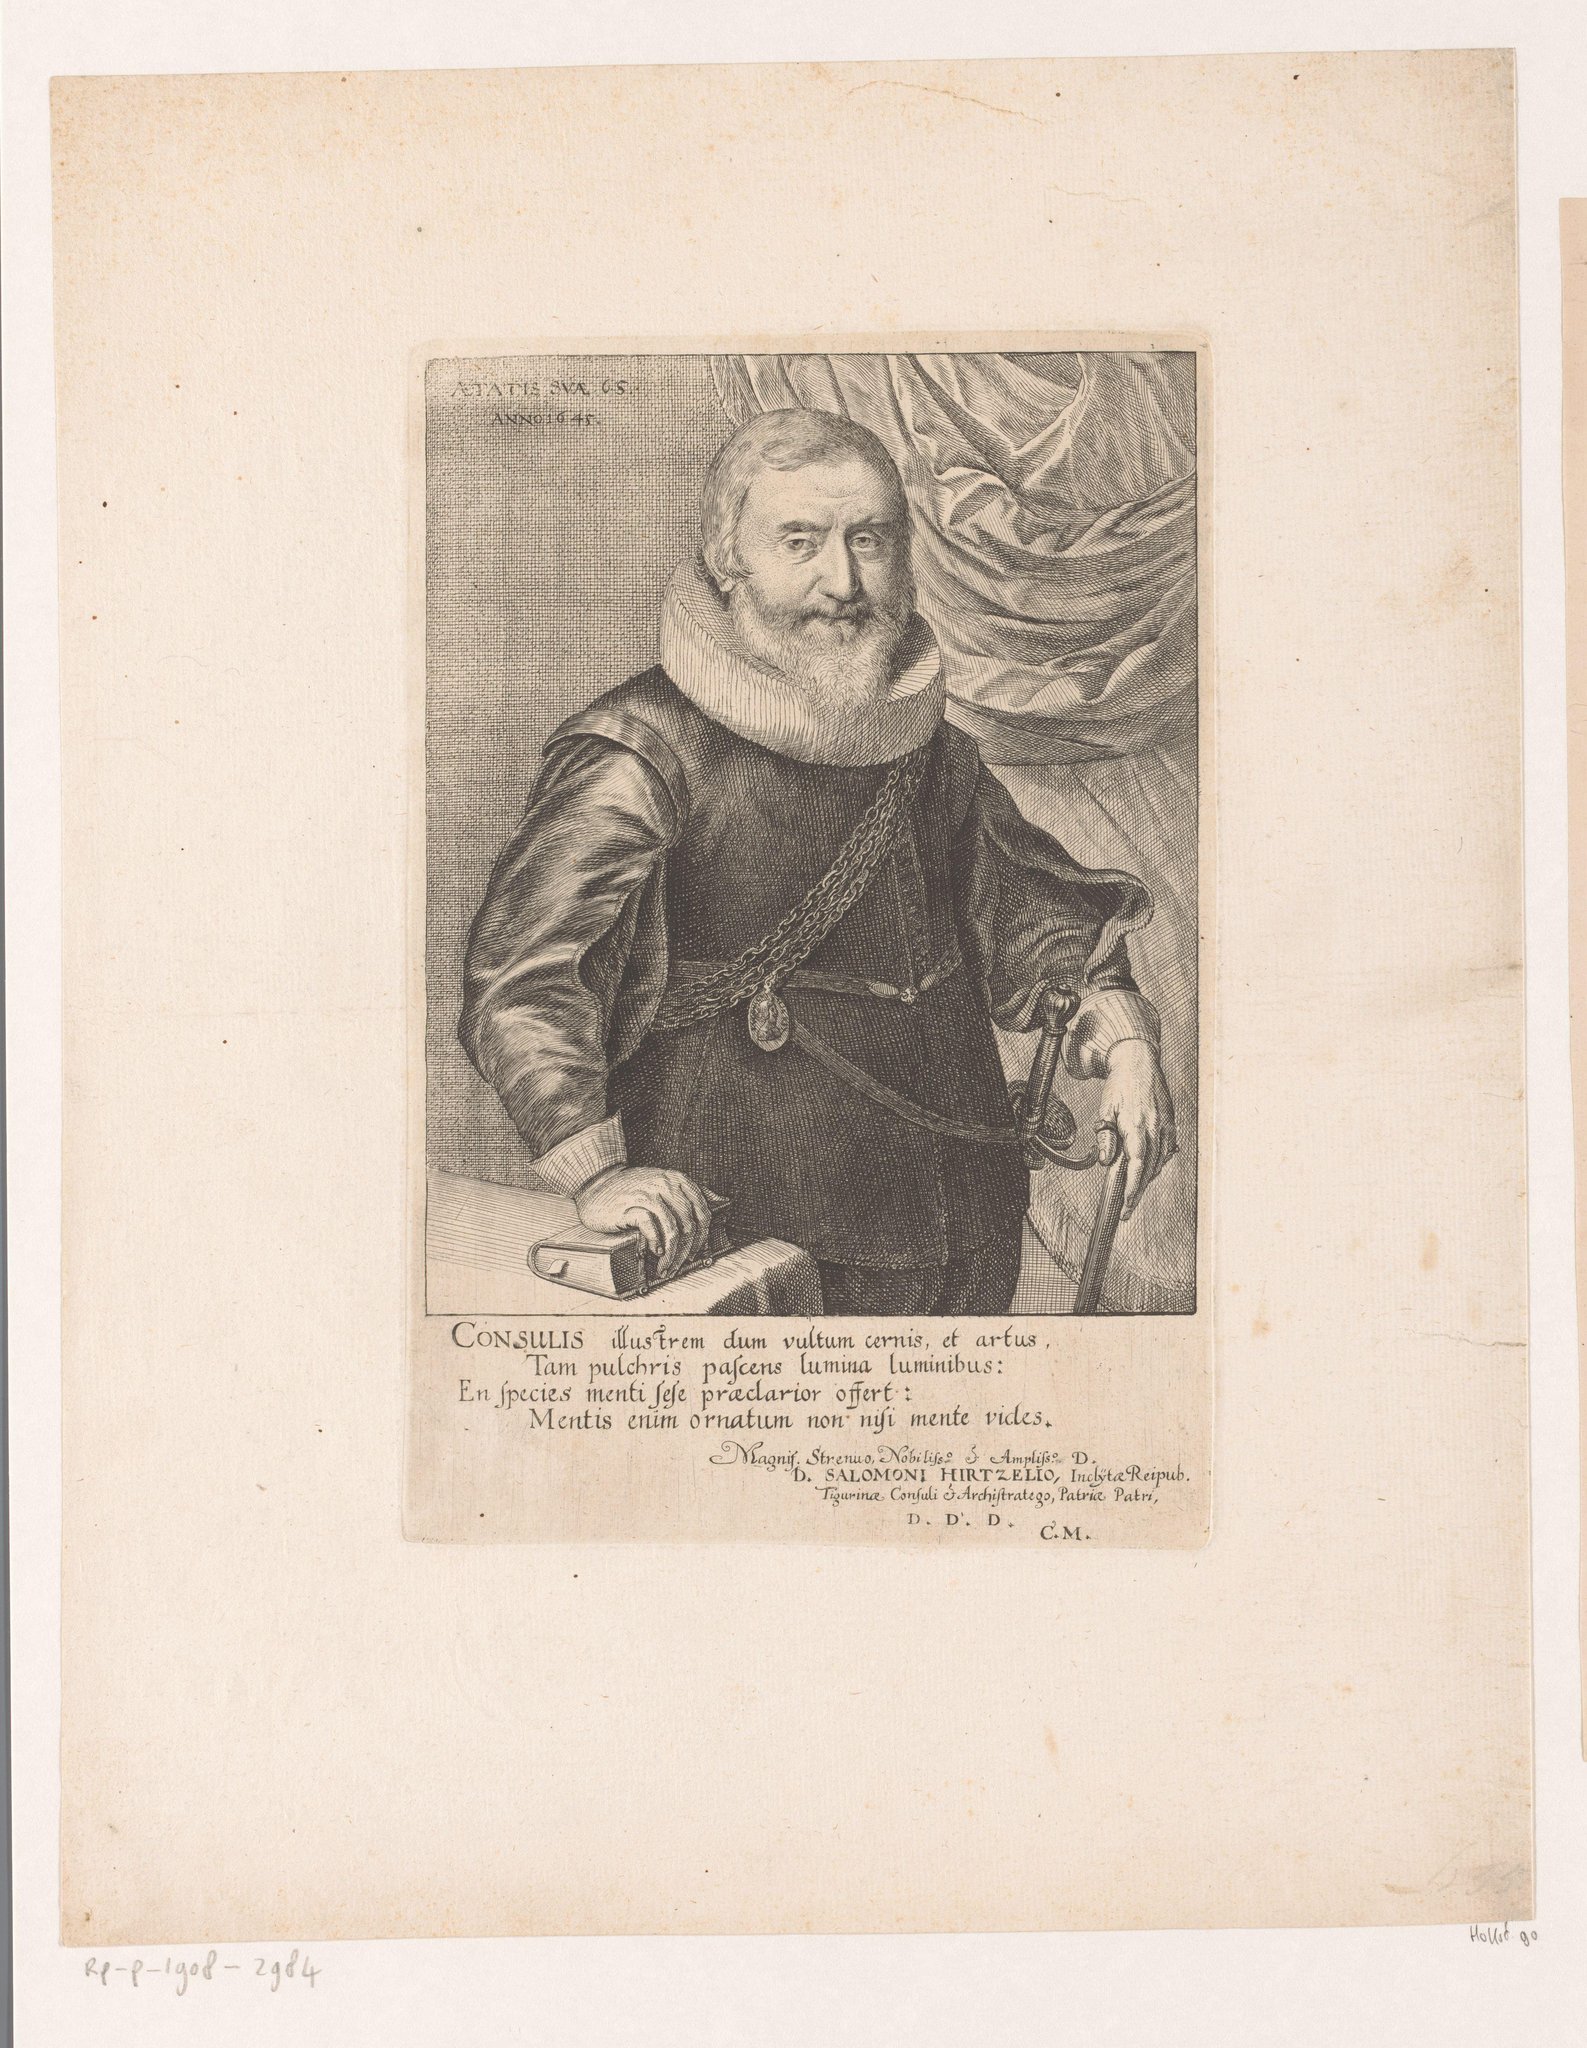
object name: print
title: Portret van Salomon Hirzel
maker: conrad meyer (i)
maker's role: painter, print maker, publisher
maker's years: 1618-1689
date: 1628-1689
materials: paper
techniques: engraving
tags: mayor, burgomaster, other non-personal regalia, e.g. mayor chain, historical persons, hacking and thrusting weapons: sword, book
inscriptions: collector's mark: Lugt 2228